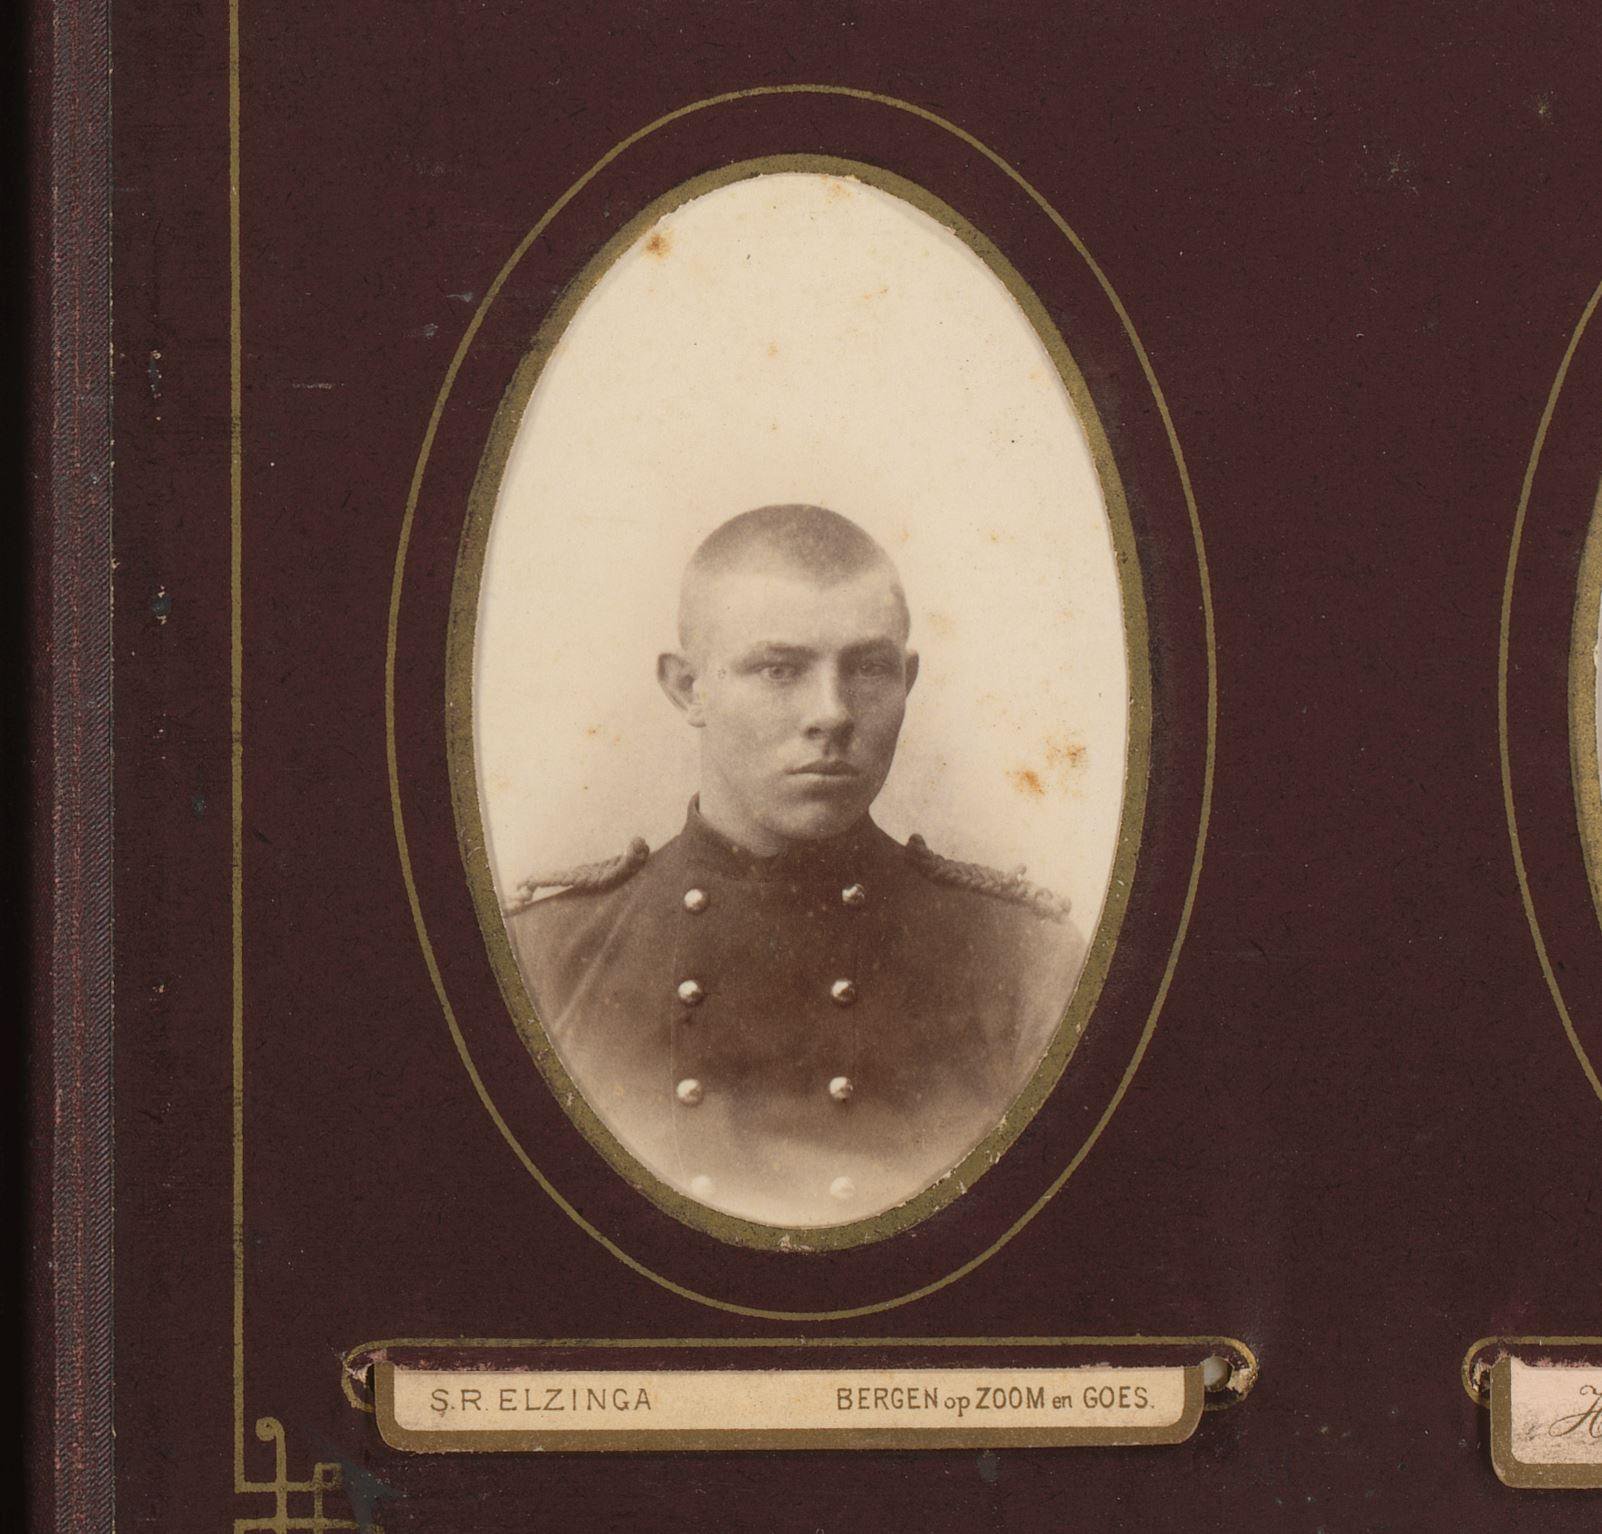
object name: album leaf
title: Portret van een jonge man in militair uniform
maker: sytze reinder elzinga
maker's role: fotograaf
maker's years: 1858-1912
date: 1880-1900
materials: cardboard, photographic support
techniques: albumen print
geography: netherlands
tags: historical persons, youth, adolescent, (military) uniforms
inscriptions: inscription: ‘Photographische Kunst-Inrichting/ van/ S. R. Elzinga/ Photographie, Crayons/ Pastel, Aquarel en Olie verf/ Auvergnestraat/ Bergen op Zoom/ en/ Goes./ Nieuwste Inrichting voor vergrootingen/ naar album-af kleinere portretjes.’